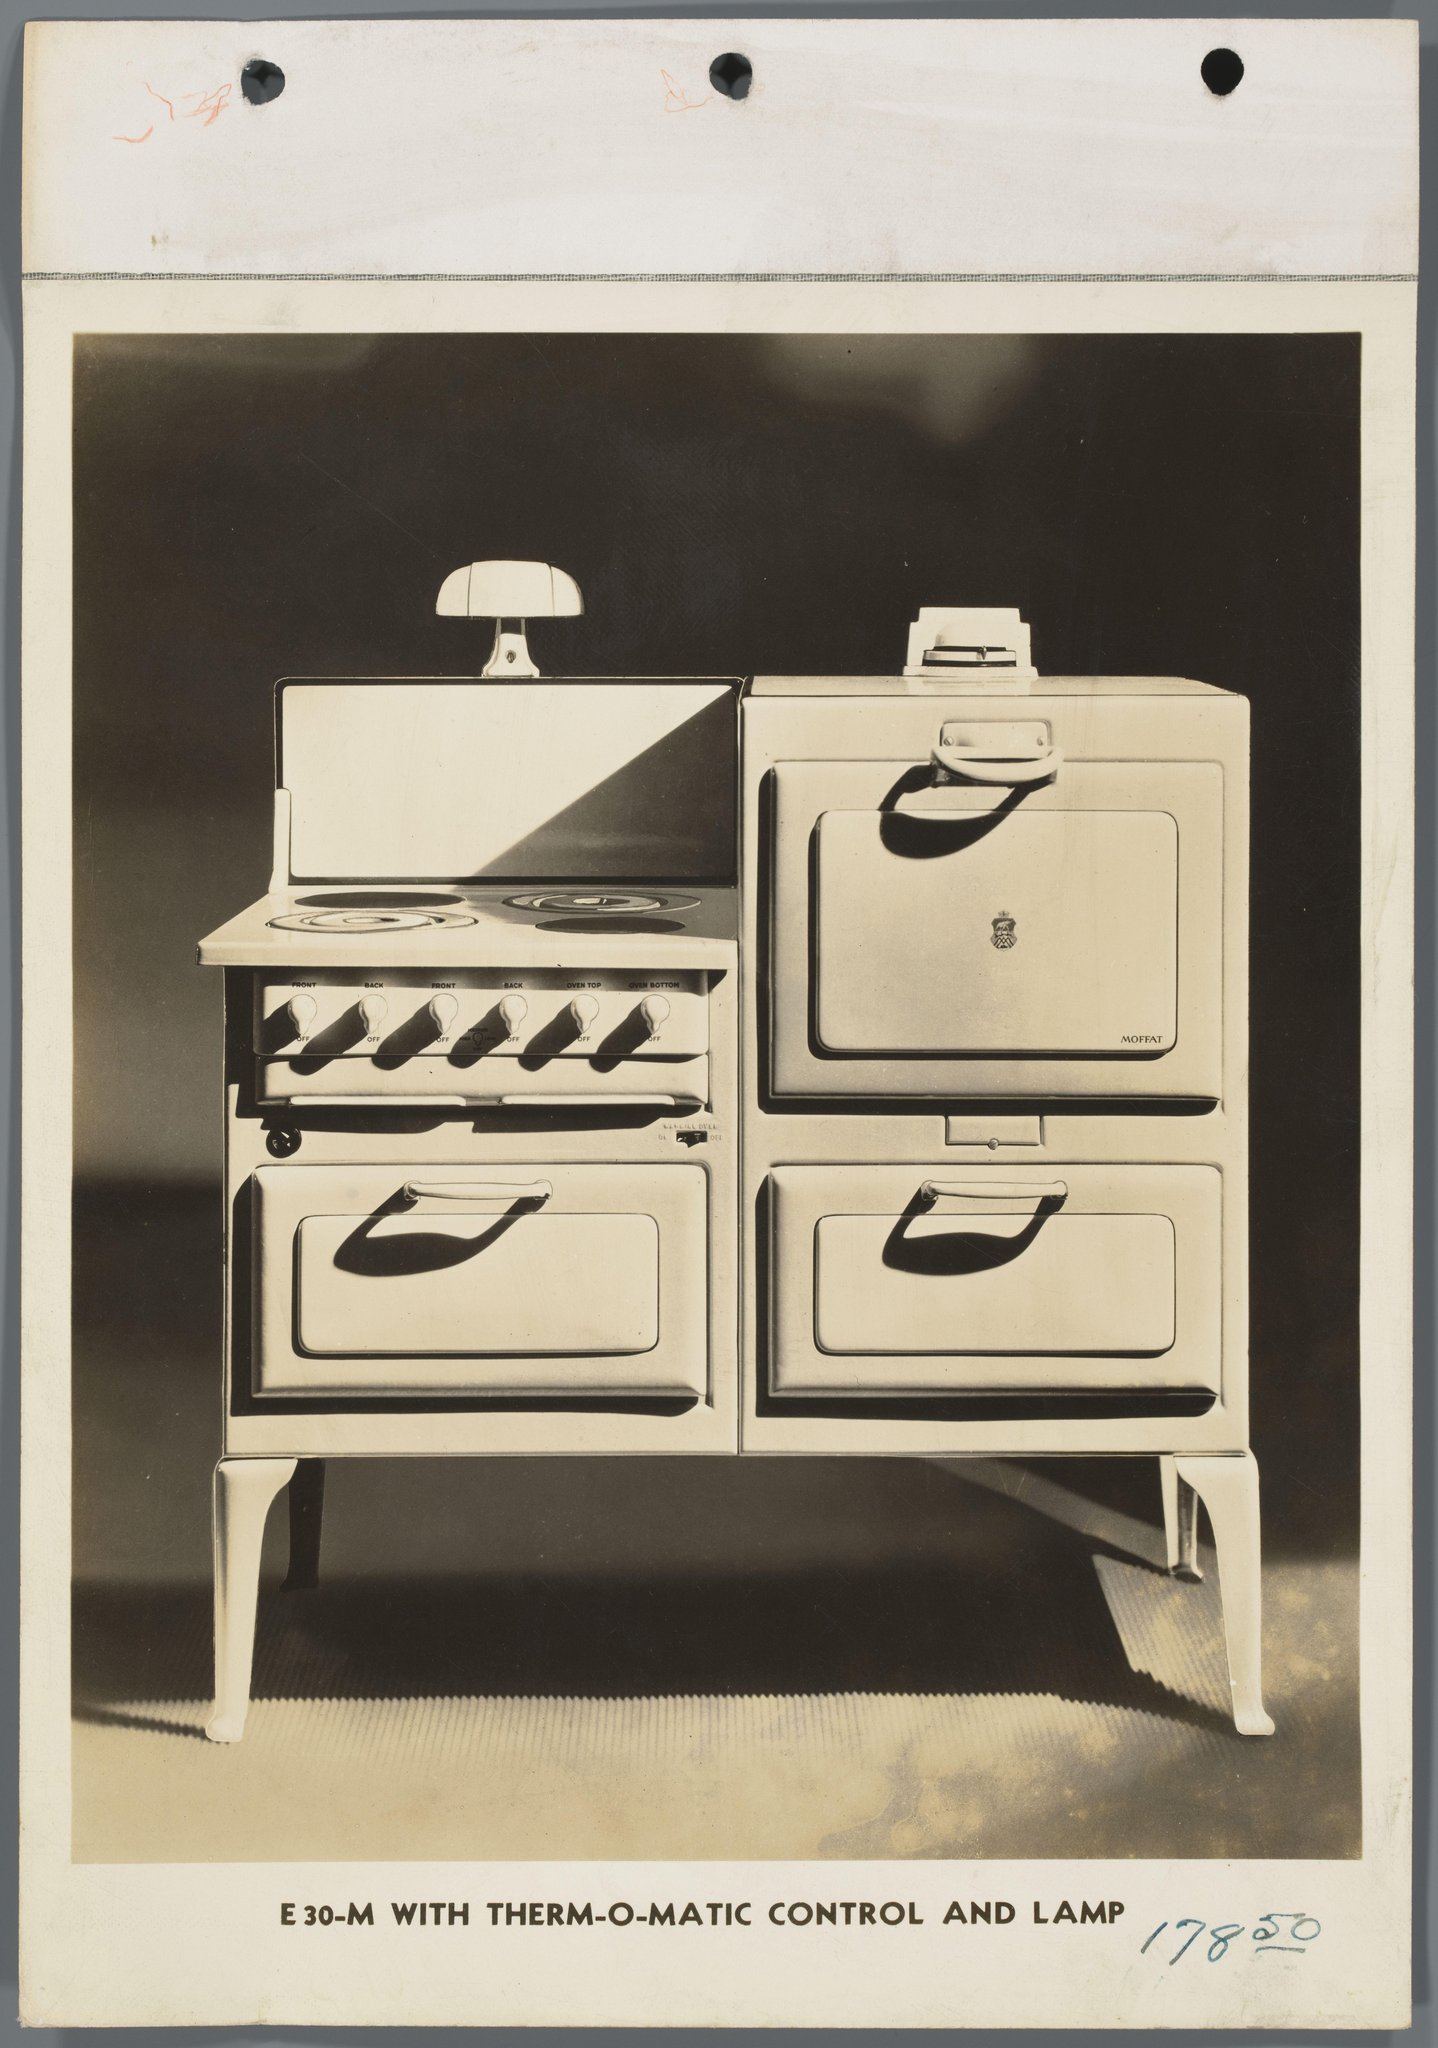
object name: photograph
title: Foto van Moffat ovens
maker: Anonymous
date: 1935-1940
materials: paper, photographic support, textile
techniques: gelatin silver print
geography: canada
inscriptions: inscription: ‘E 30-M WITH THERM-O-MATIC CONTROL AND LAMP’, inscription: ‘17850’